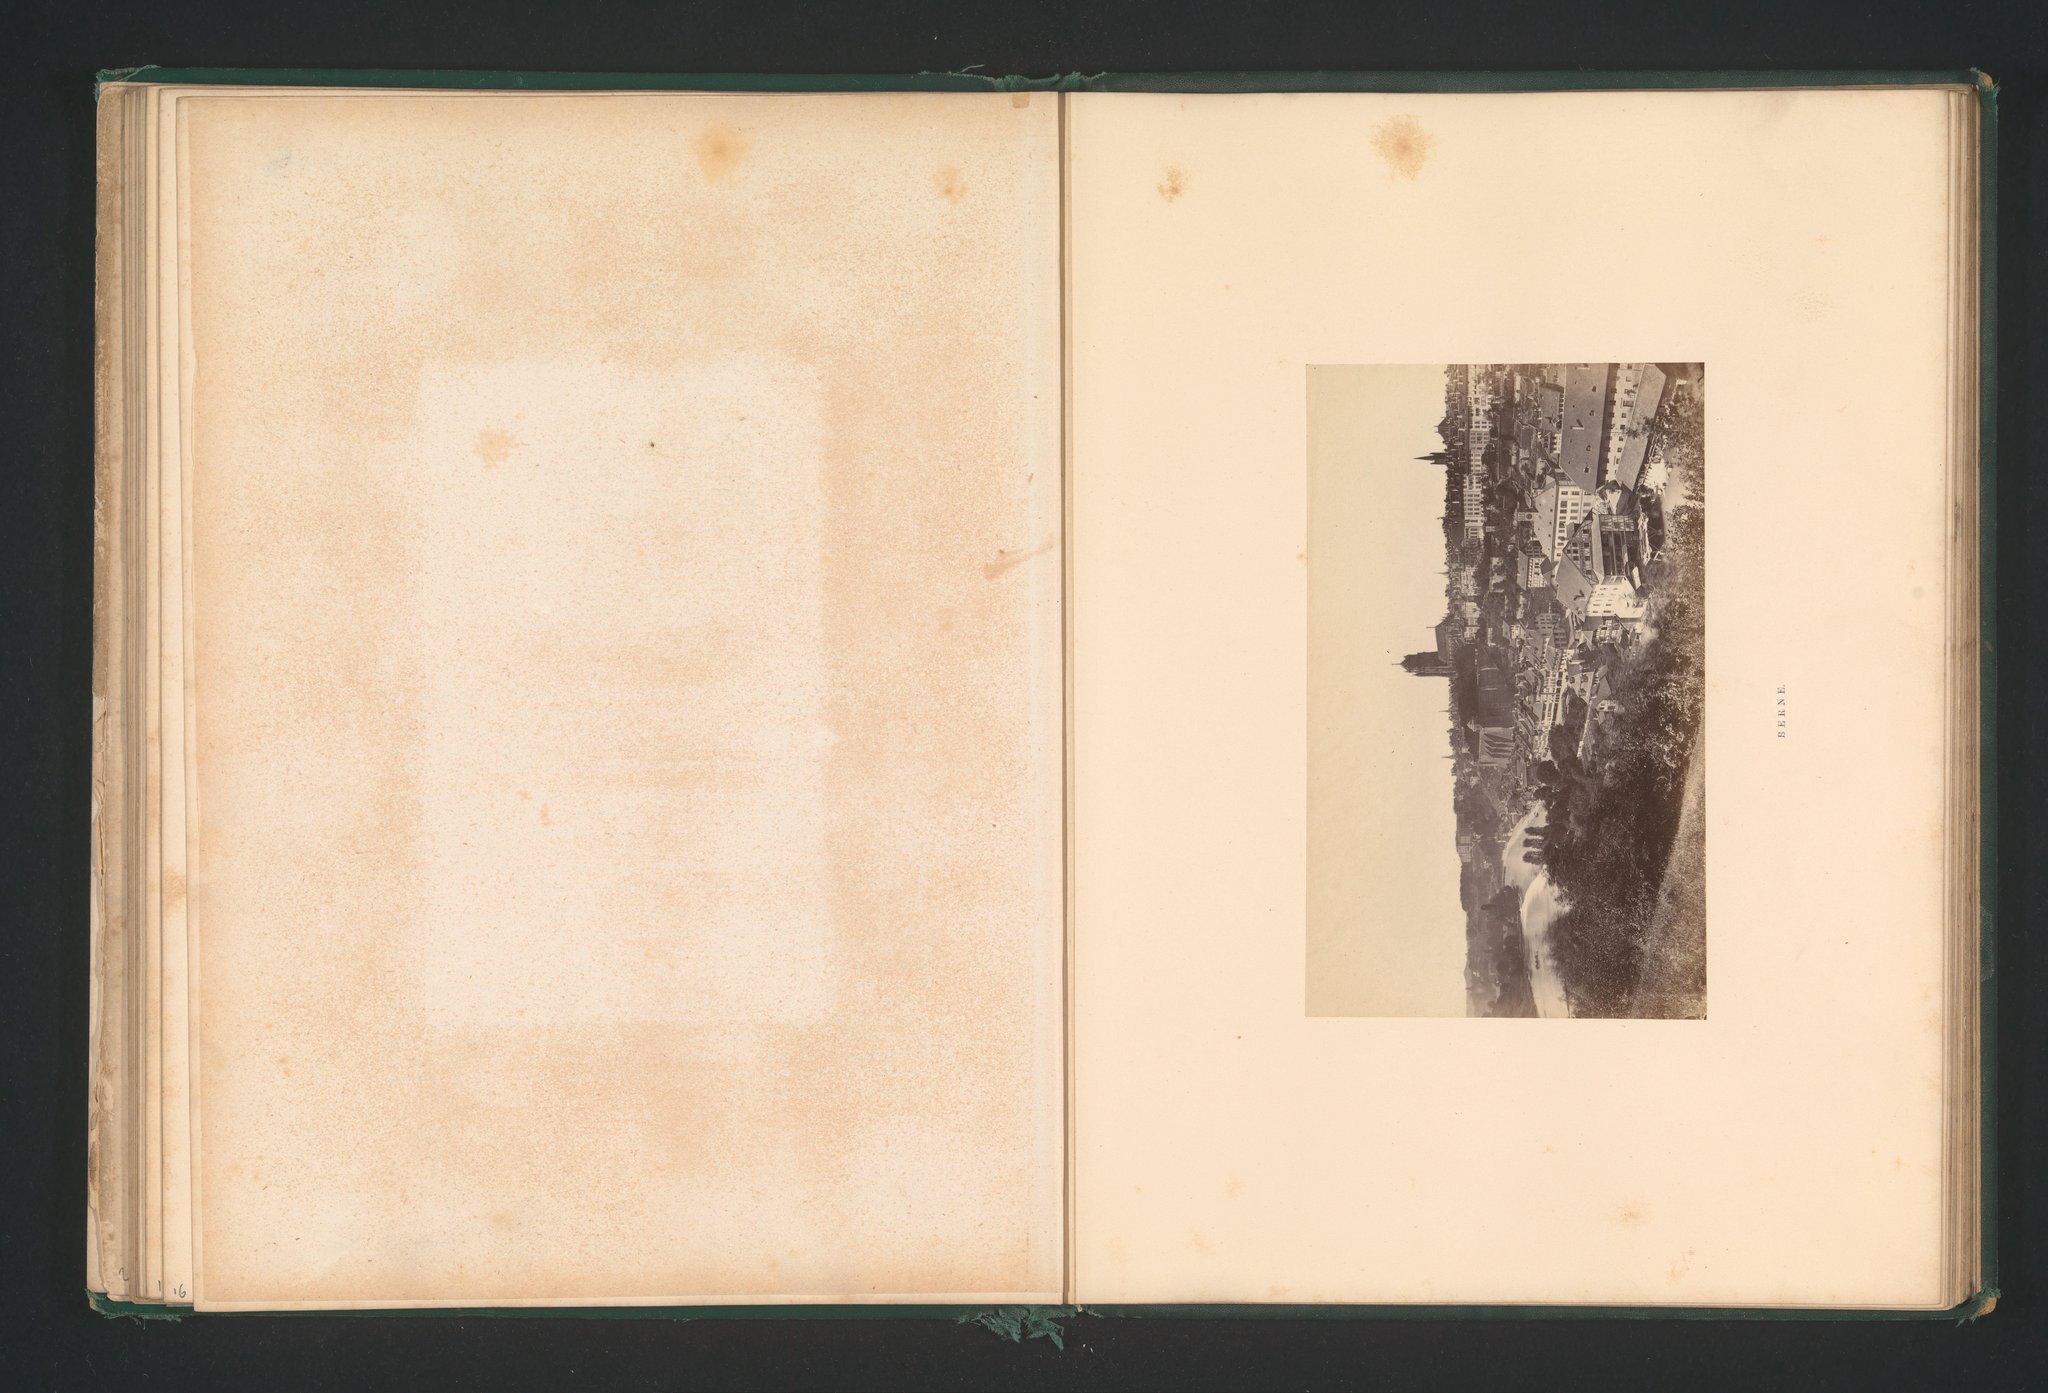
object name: photograph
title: Berne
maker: stephen thompson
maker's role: fotograaf, schrijver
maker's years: 1831-1893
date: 1863-1868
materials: photographic support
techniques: albumen print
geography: bern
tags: city-view in general; 'veduta'